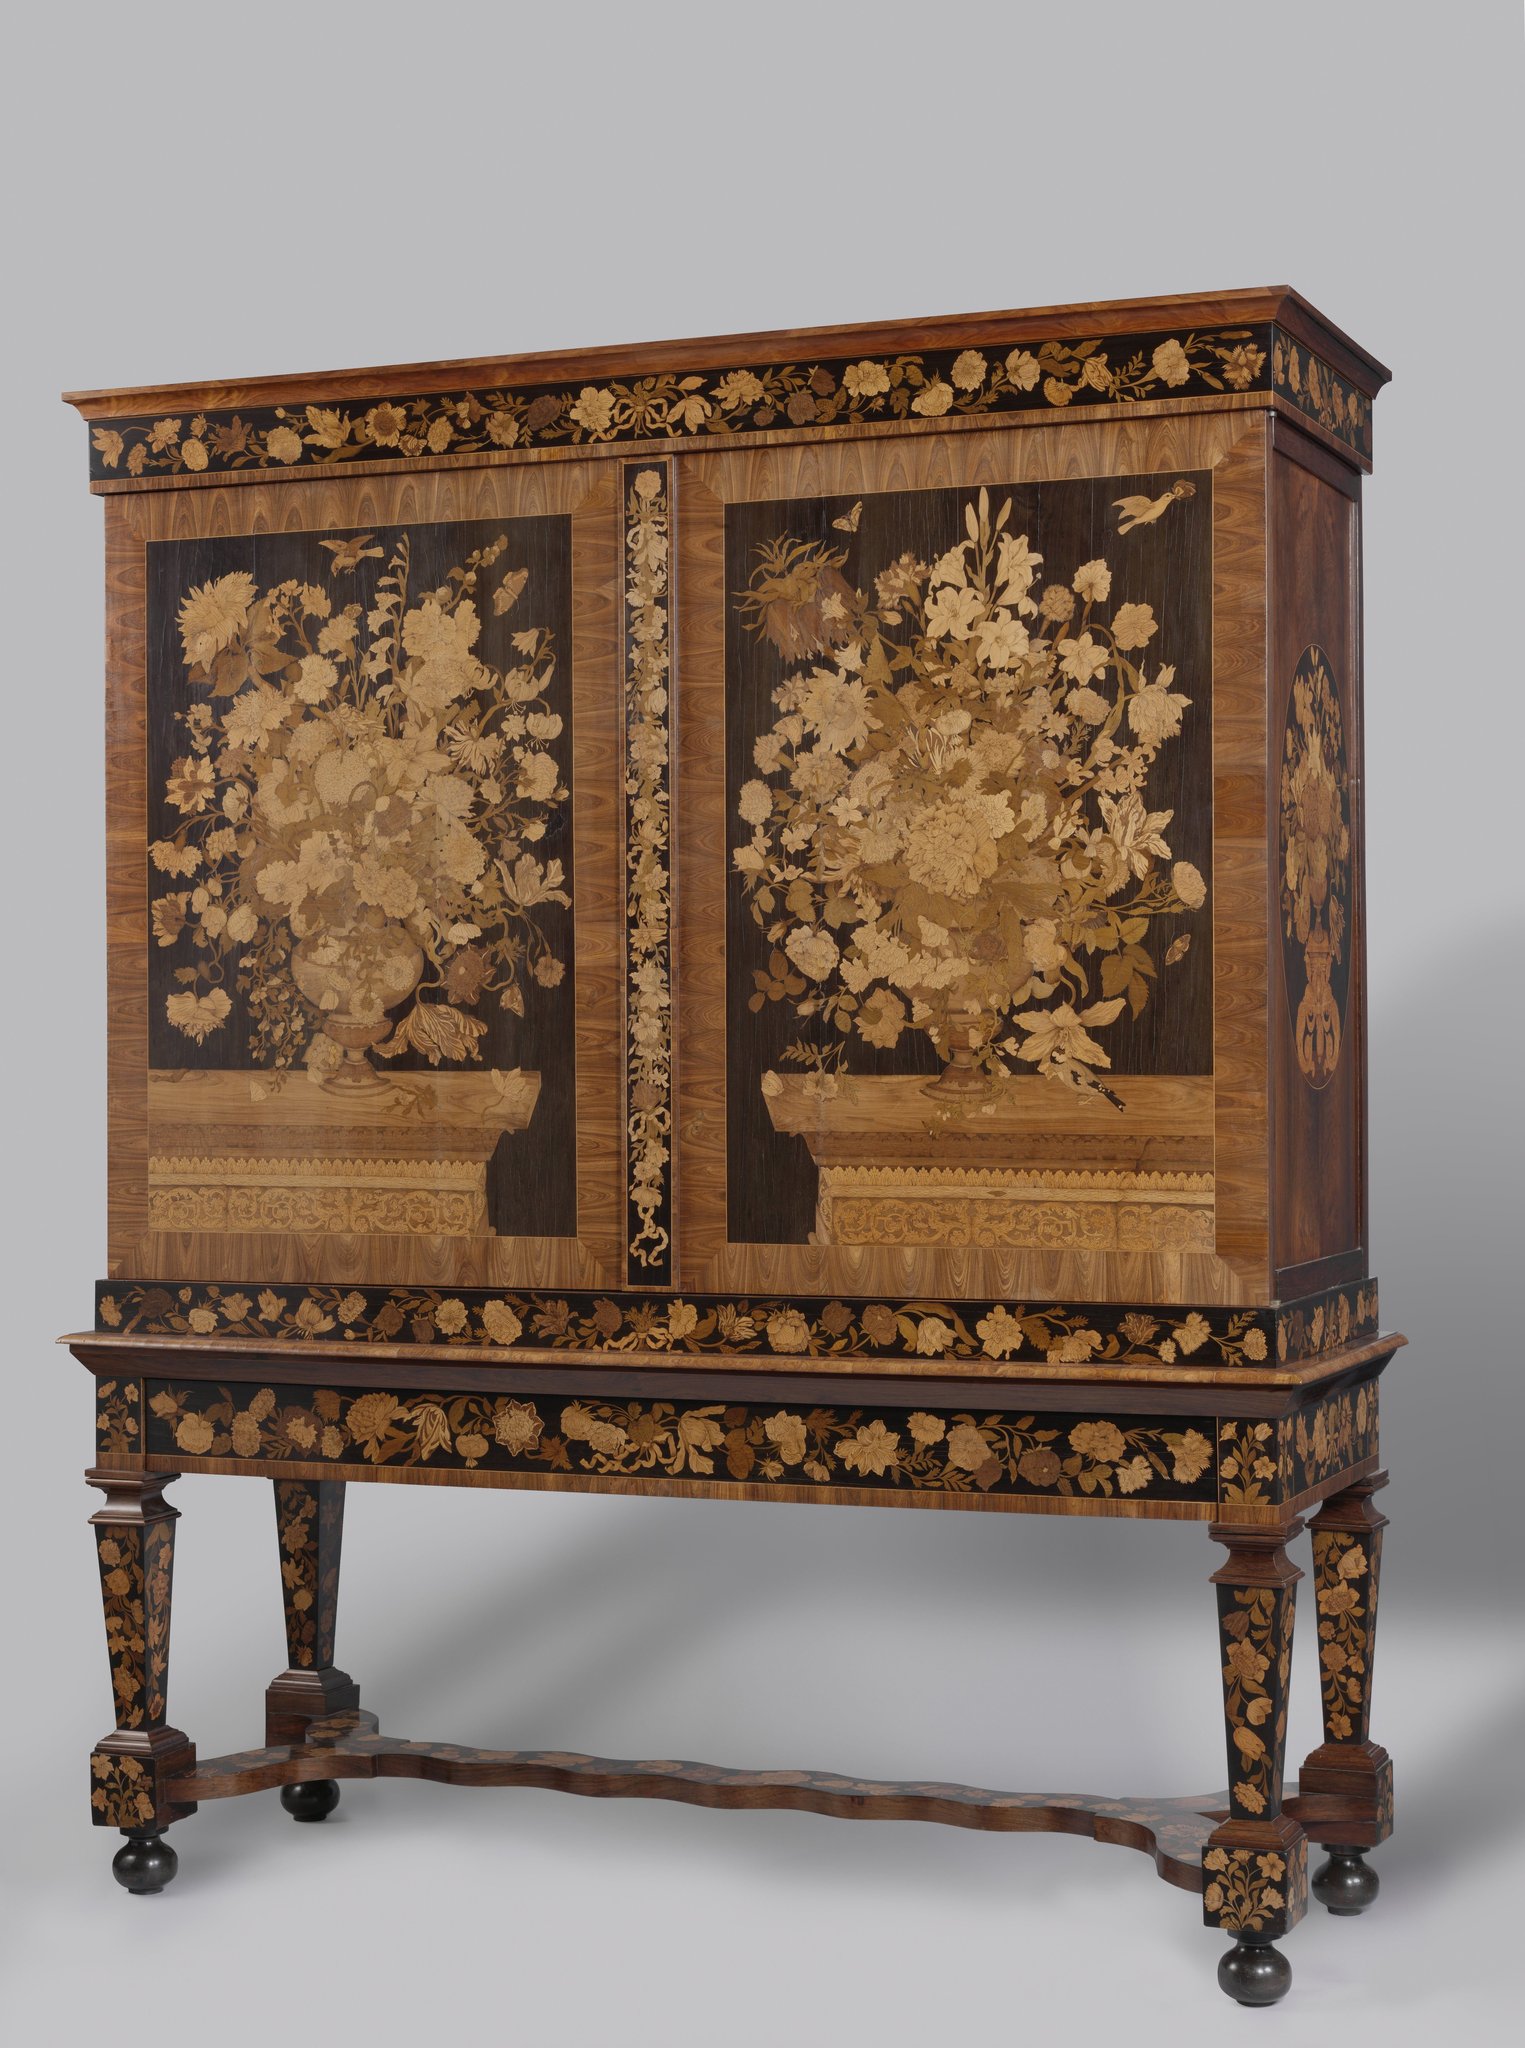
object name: cabinet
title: Cabinet with Inlaid Flower Vases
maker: jan van mekeren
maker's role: furniture worker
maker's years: 1648-1733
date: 1695-1710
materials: wood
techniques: marquetry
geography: amsterdam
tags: flowers in a vase, flowers ~ ornament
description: This cabinet was made by one of the most famous Dutch cabinetmakers of the 17th century: Jan van Mekeren. At that time, a cabinet by him cost even more than a painting by Rembrandt. Using a fretsaw, he cut all kinds of shapes from as many as 15 types of variously coloured wood. He then glued the small pieces together, like a puzzle. For instance, on the doors he made bouquets of flowers, and do you also see the birds and butterflies?